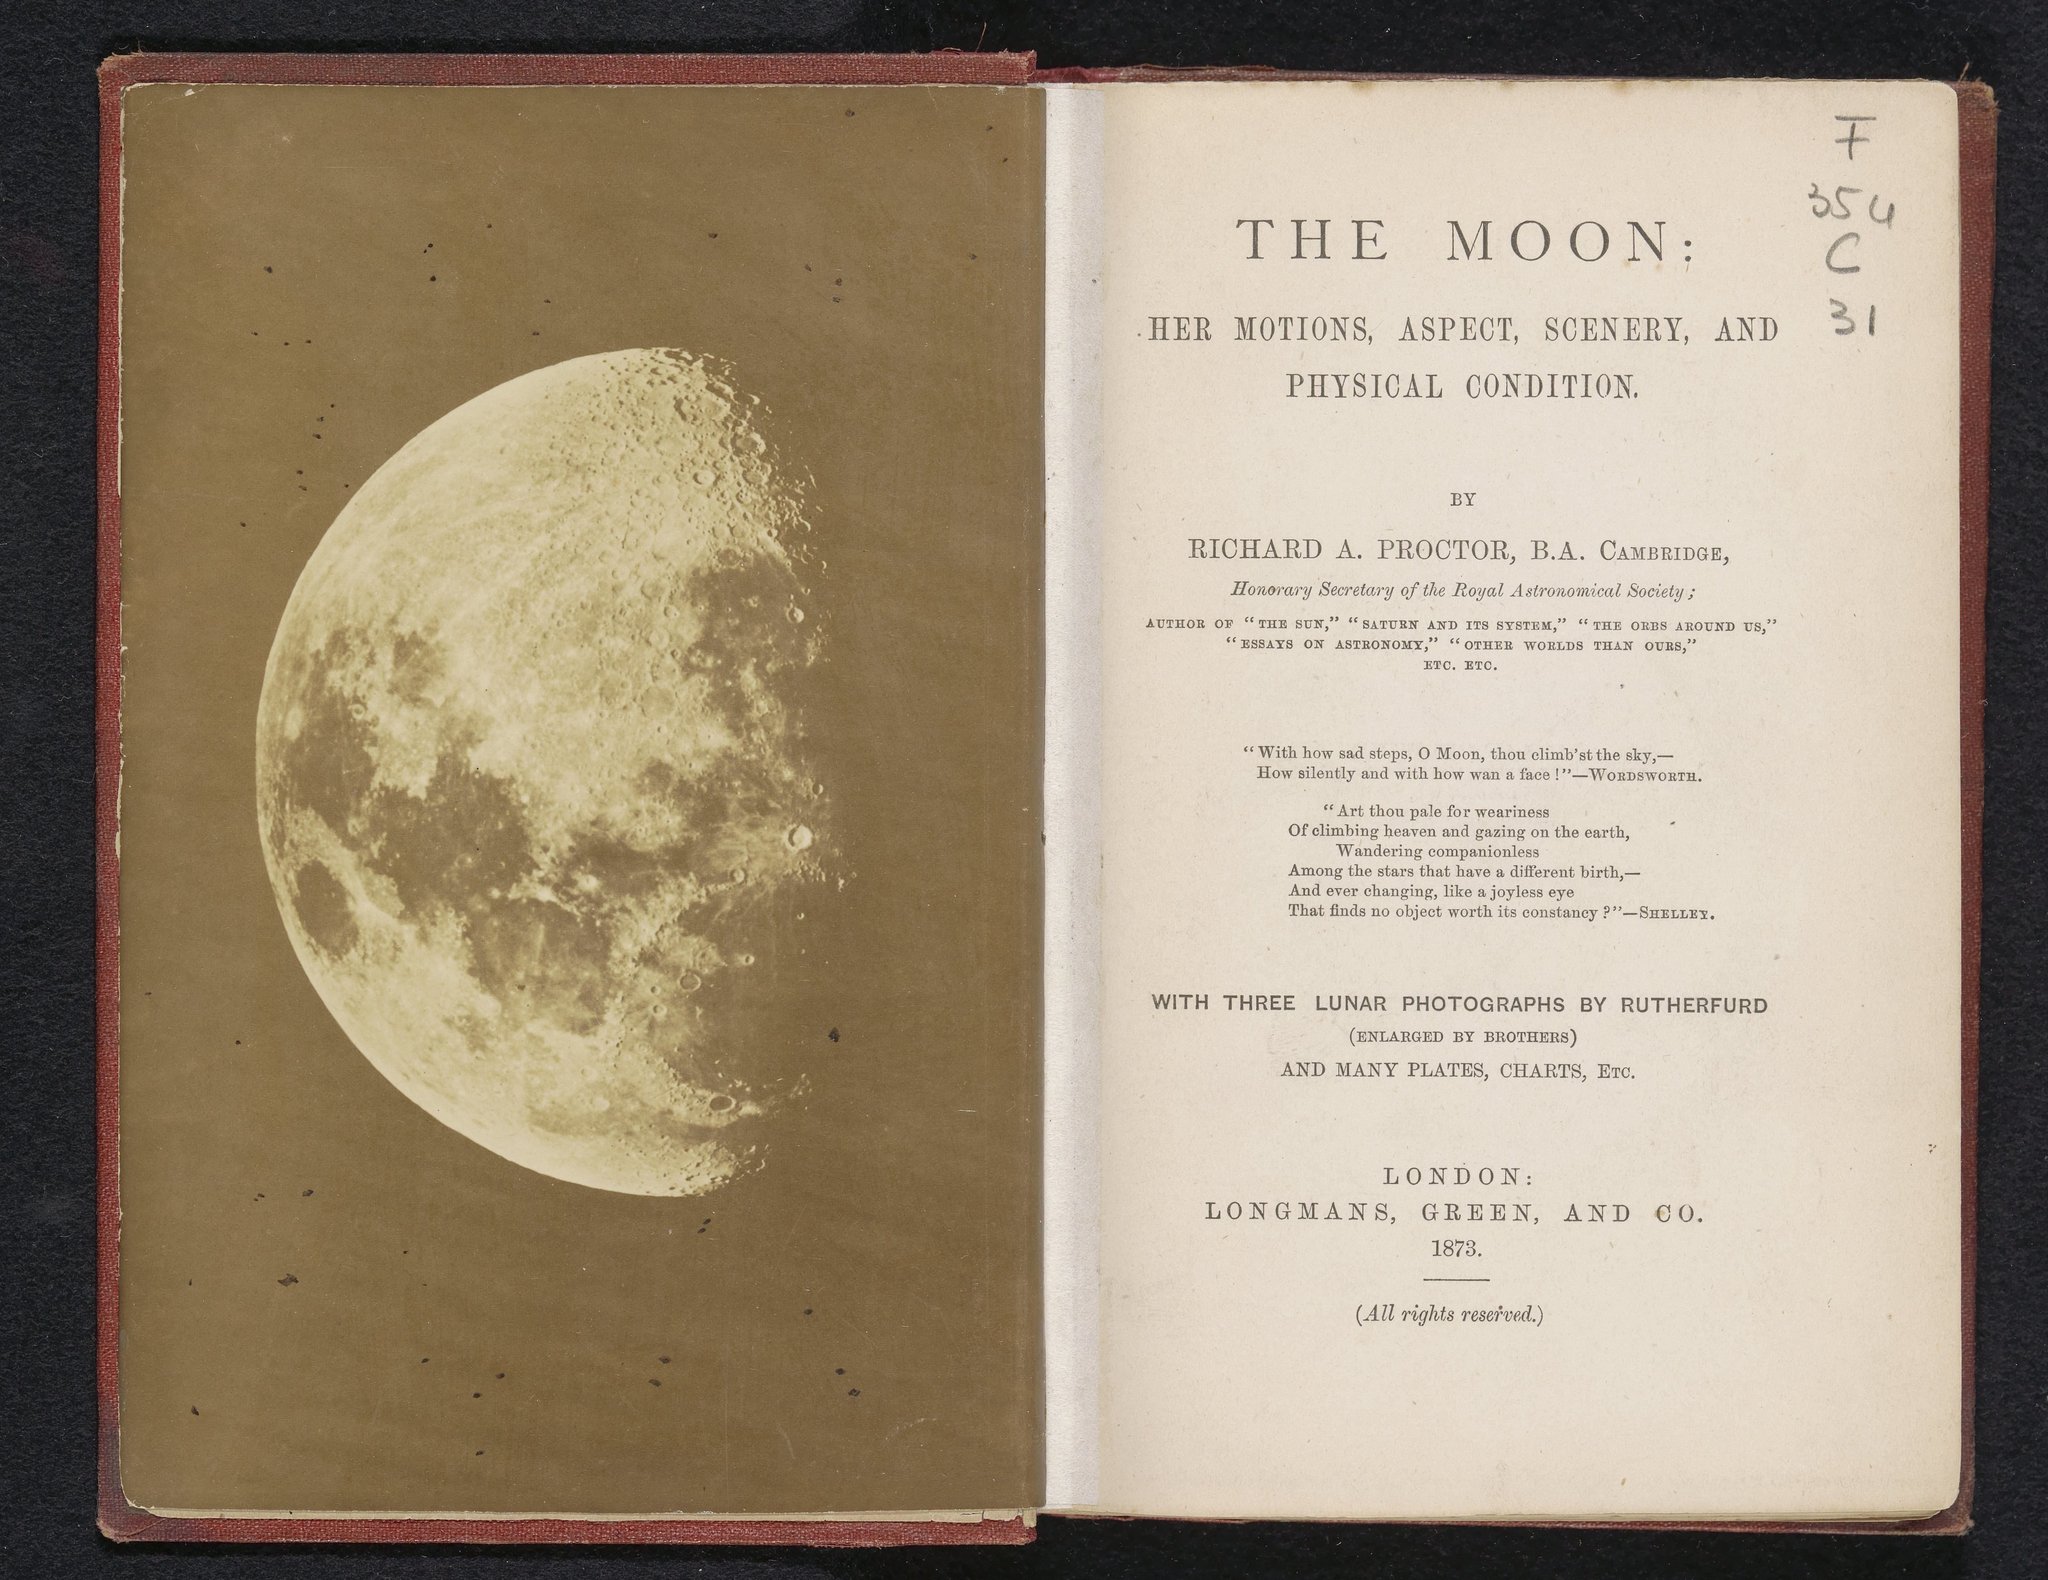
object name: book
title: The moon, her motions, aspect, scenery, and physical condition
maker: richard anthony proctor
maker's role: astronoom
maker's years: 1837-1888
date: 1873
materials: cardboard, linen, paper, photographic support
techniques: albumen print, lithograph, printing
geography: london